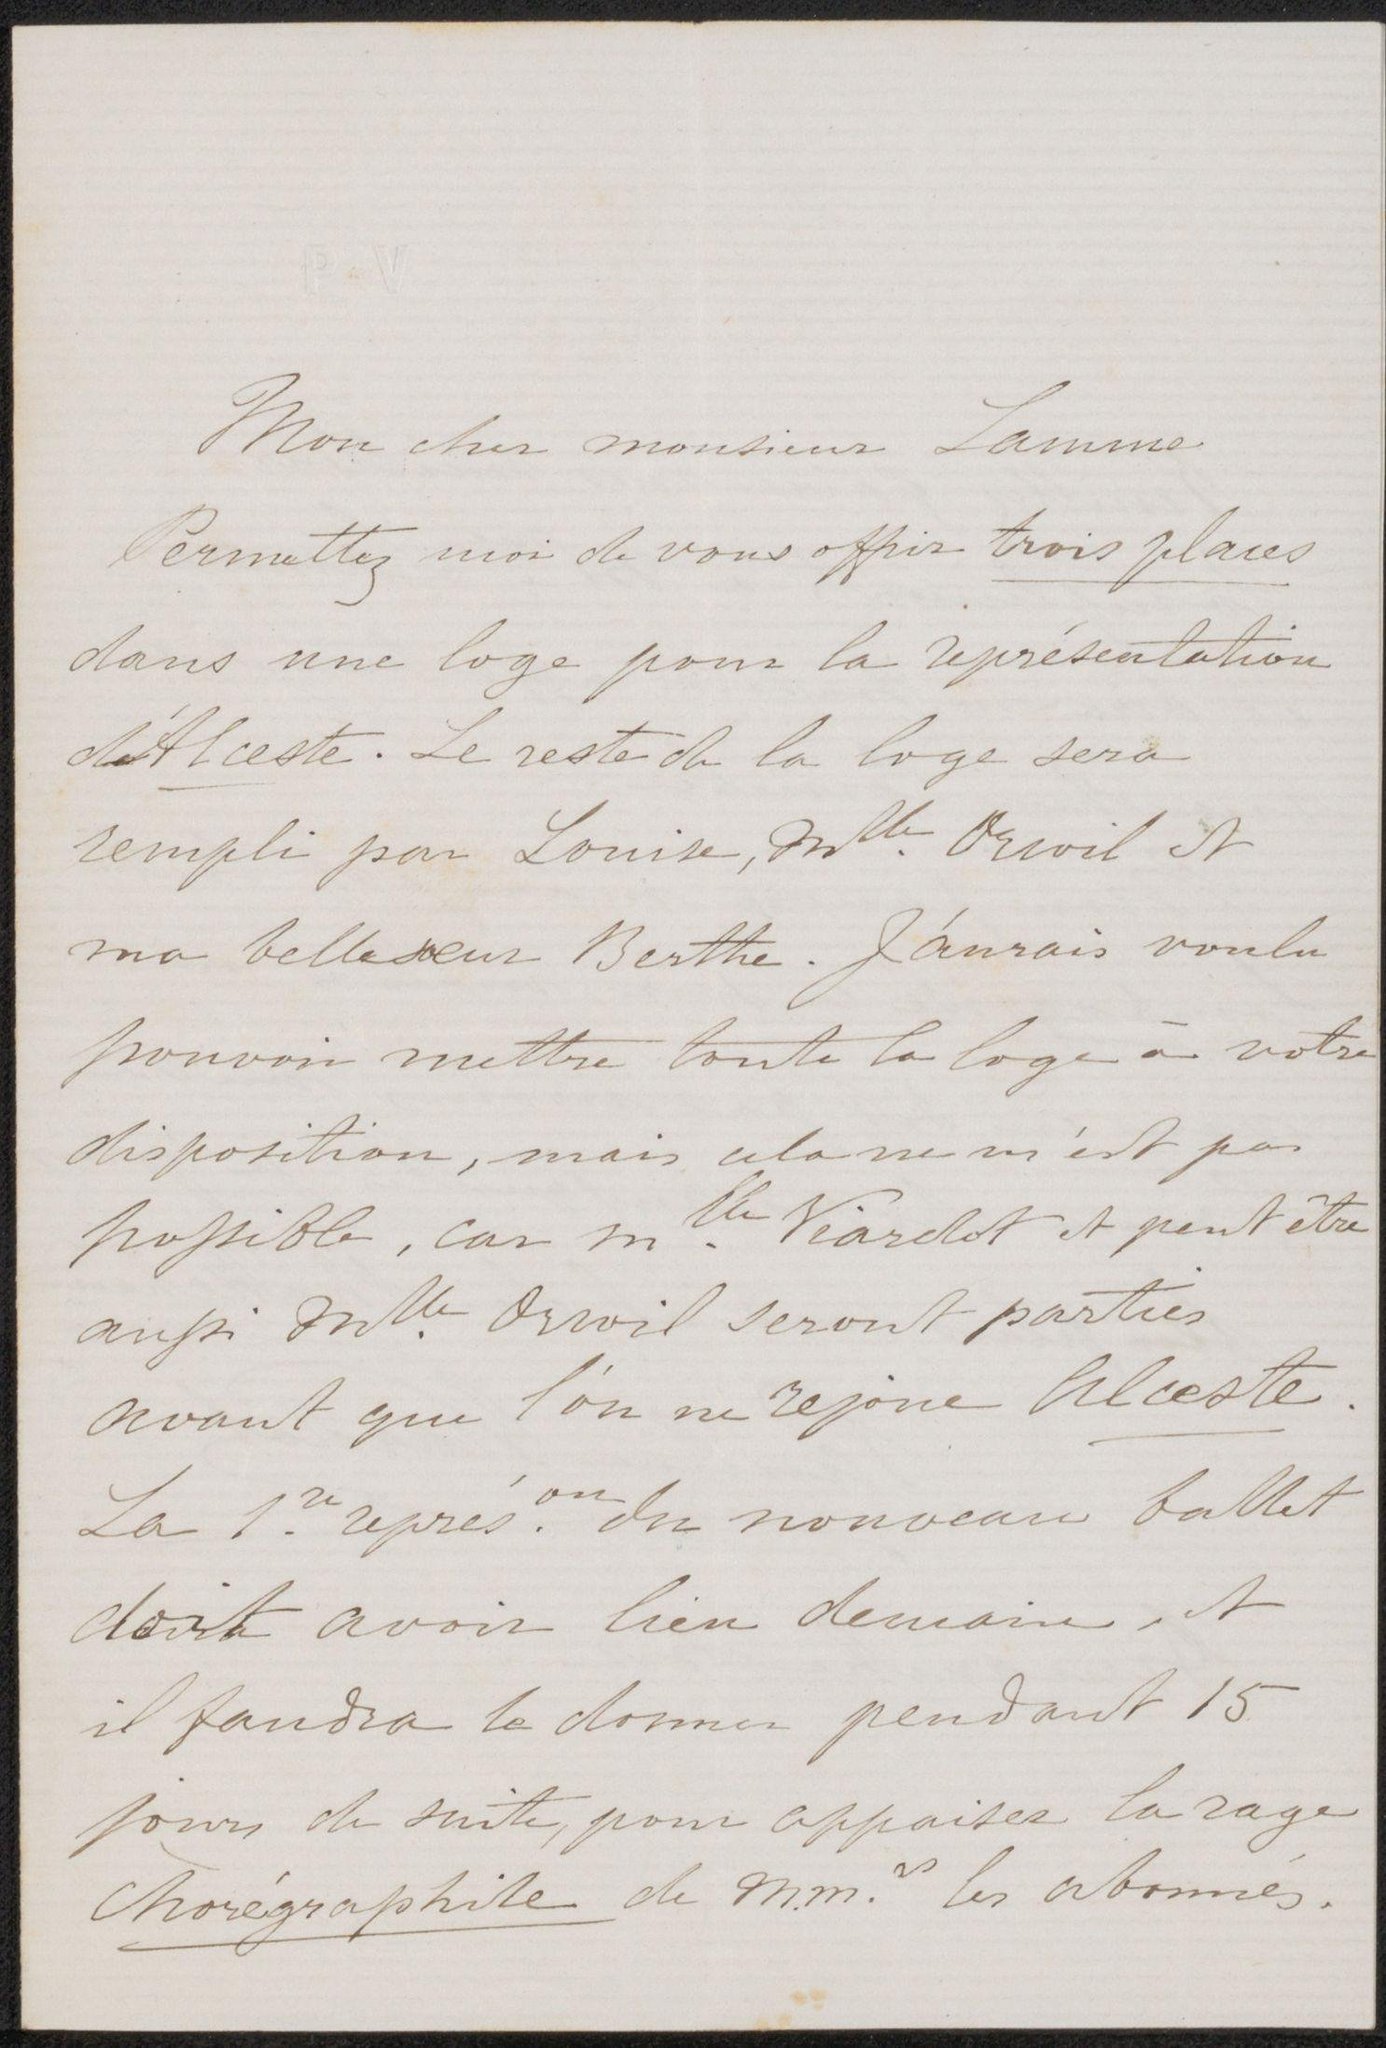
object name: letter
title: Brief aan Ary Johannes Lamme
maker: pauline viardot-garcia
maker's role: operazanger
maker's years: 1821-1910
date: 1831-1900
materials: ink, paper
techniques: pen, writing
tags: ary johannes lamme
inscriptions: collector's mark: Lugt 2228, initials: ‘P-V’